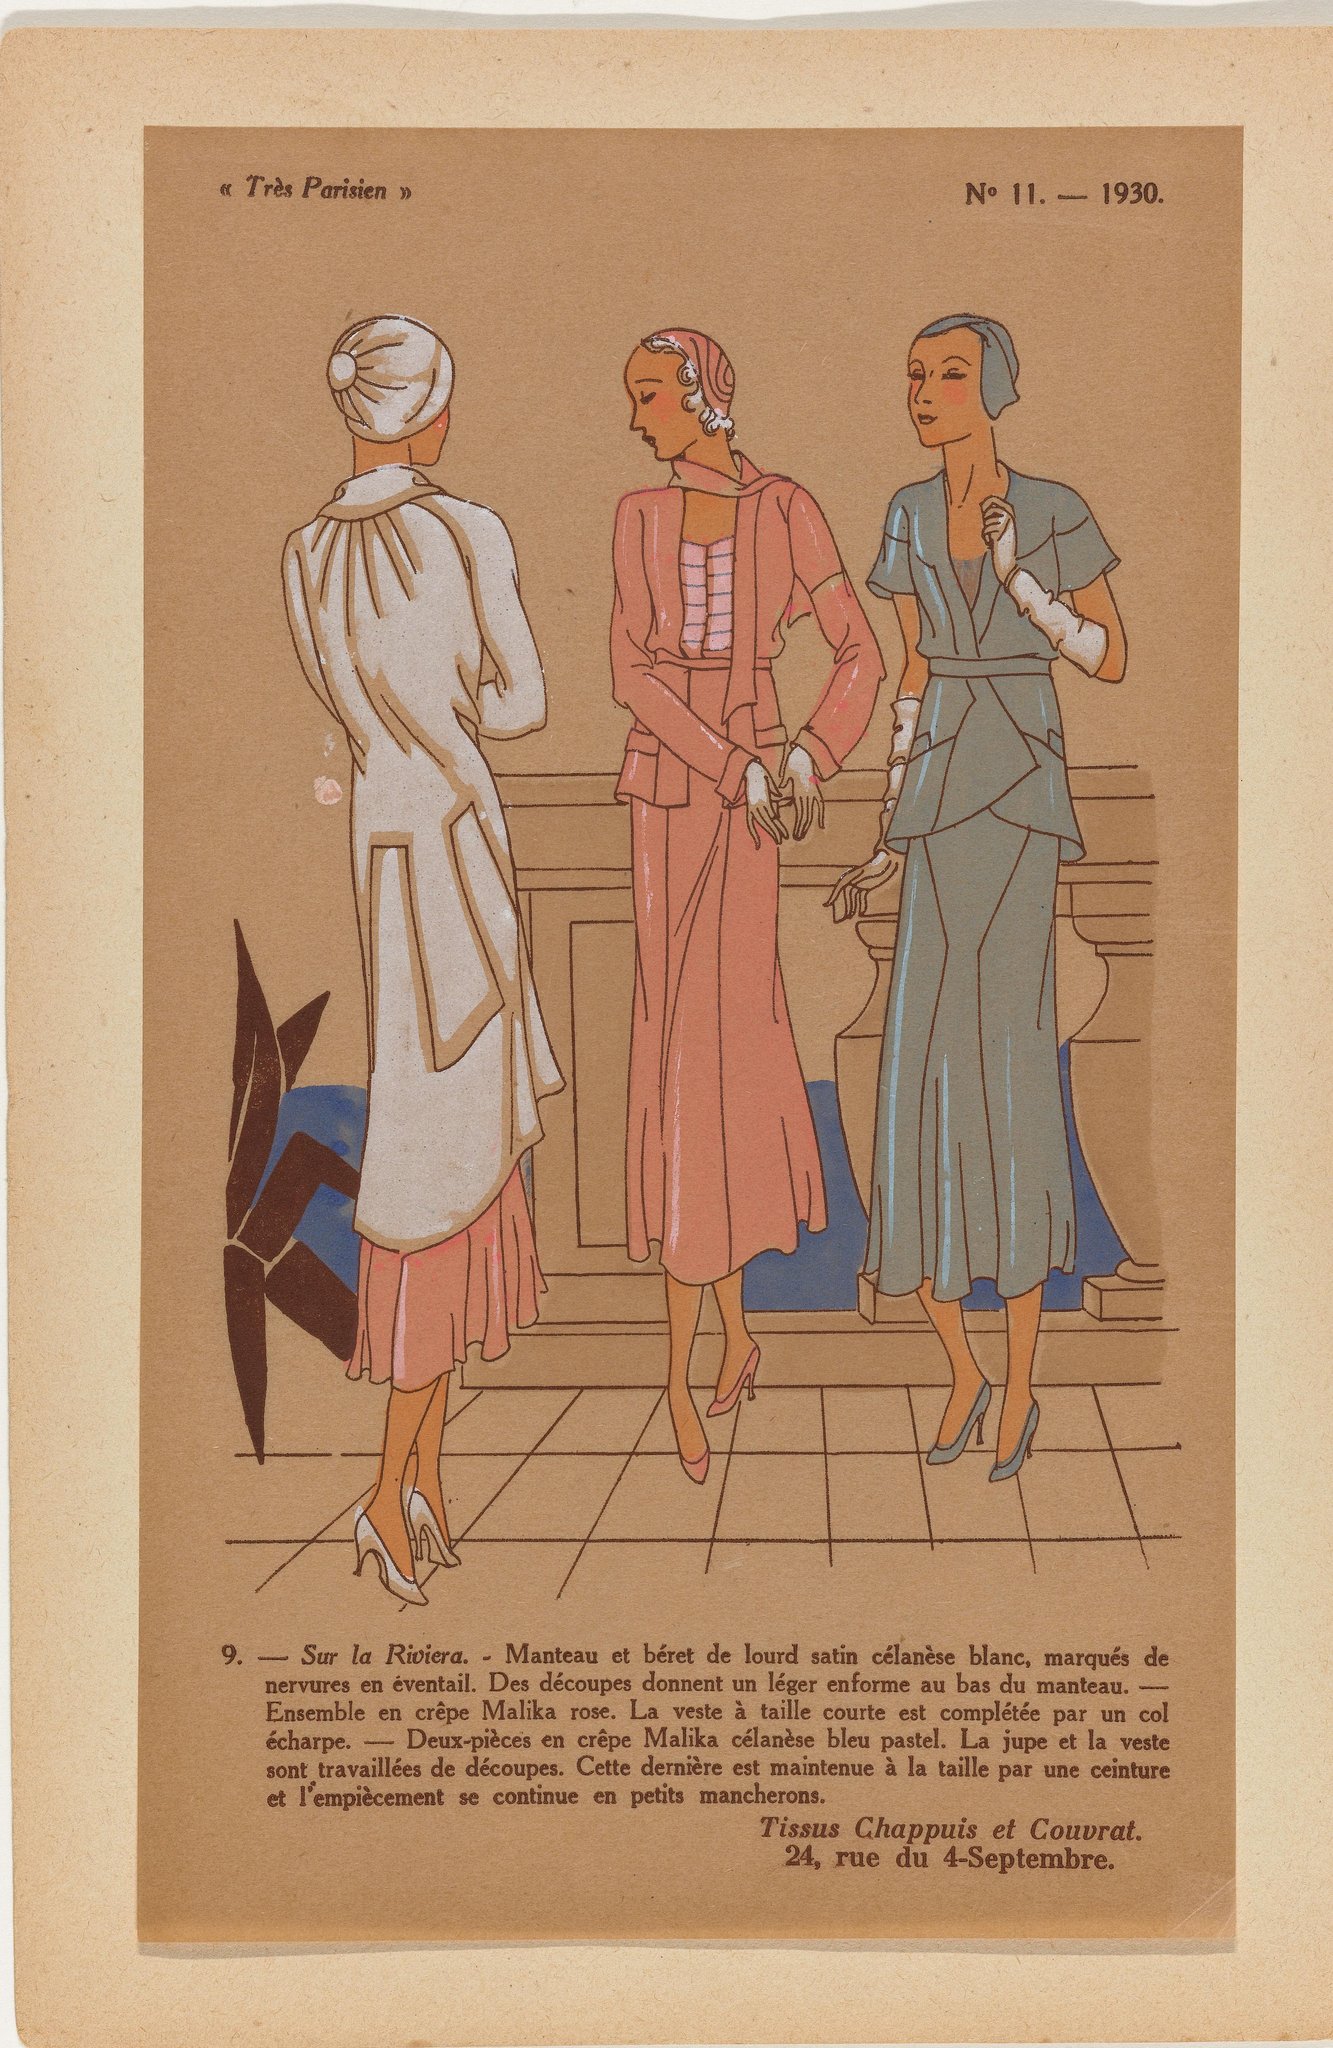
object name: fashion print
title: Très Parisien, 1930, No. 11: 9. - Sur la Riviera...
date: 1930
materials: paper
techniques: hand coloring, letterpress printing, lithography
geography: paris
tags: gloves, mittens (long gloves) (+ women's clothes), head-gear: beret (+ women's clothes), ensembles of pieces of clothing (two piece suit) (+ women's clothes), neck-gear ~ clothing (shawl collar) (+ women's clothes), coat (+ women's clothes), belt, girdle, waistband (+ women's clothes)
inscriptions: title: ‘"Très Parisien" / No 11. - 1930.’, caption: ‘9. - Sur la Riviera. - Manteau et béret de lourd satin célanèse blanc, marqués de nervures en éventail. Des découpes donnent un léger enforme au bas du manteau. - Ensemble en crêpe Malika rose. la veste à taille courte est complétée par un col écharpe. - Deux-pièces en crêpe Malika célanèse bleu pastel. La jupe et la veste sont travaillées de découpes. Cette dernière est maintenue à la taille par une ceinture et l'empiècement se continue en petits mancherons. / Tissus Chappuis et Couvrat. 24, rue du 4-Septembre.’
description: Van links naar rechts: mantel en baret van witte 'satin célanèse' met uitwaaierende geribbelde ploien. Ensemble van roze crêpe Malika. Jas met hoge taille en sjaalkraag. Deux-pièces (mantelpak) van pastelblauwe 'crêpe Malika célanèse'. Jas met korte mouwen en ceintuur. Stoffen van Chappuis et Couvrat. Prent uit het modetijdschrift Très Parisien (1920-1936).